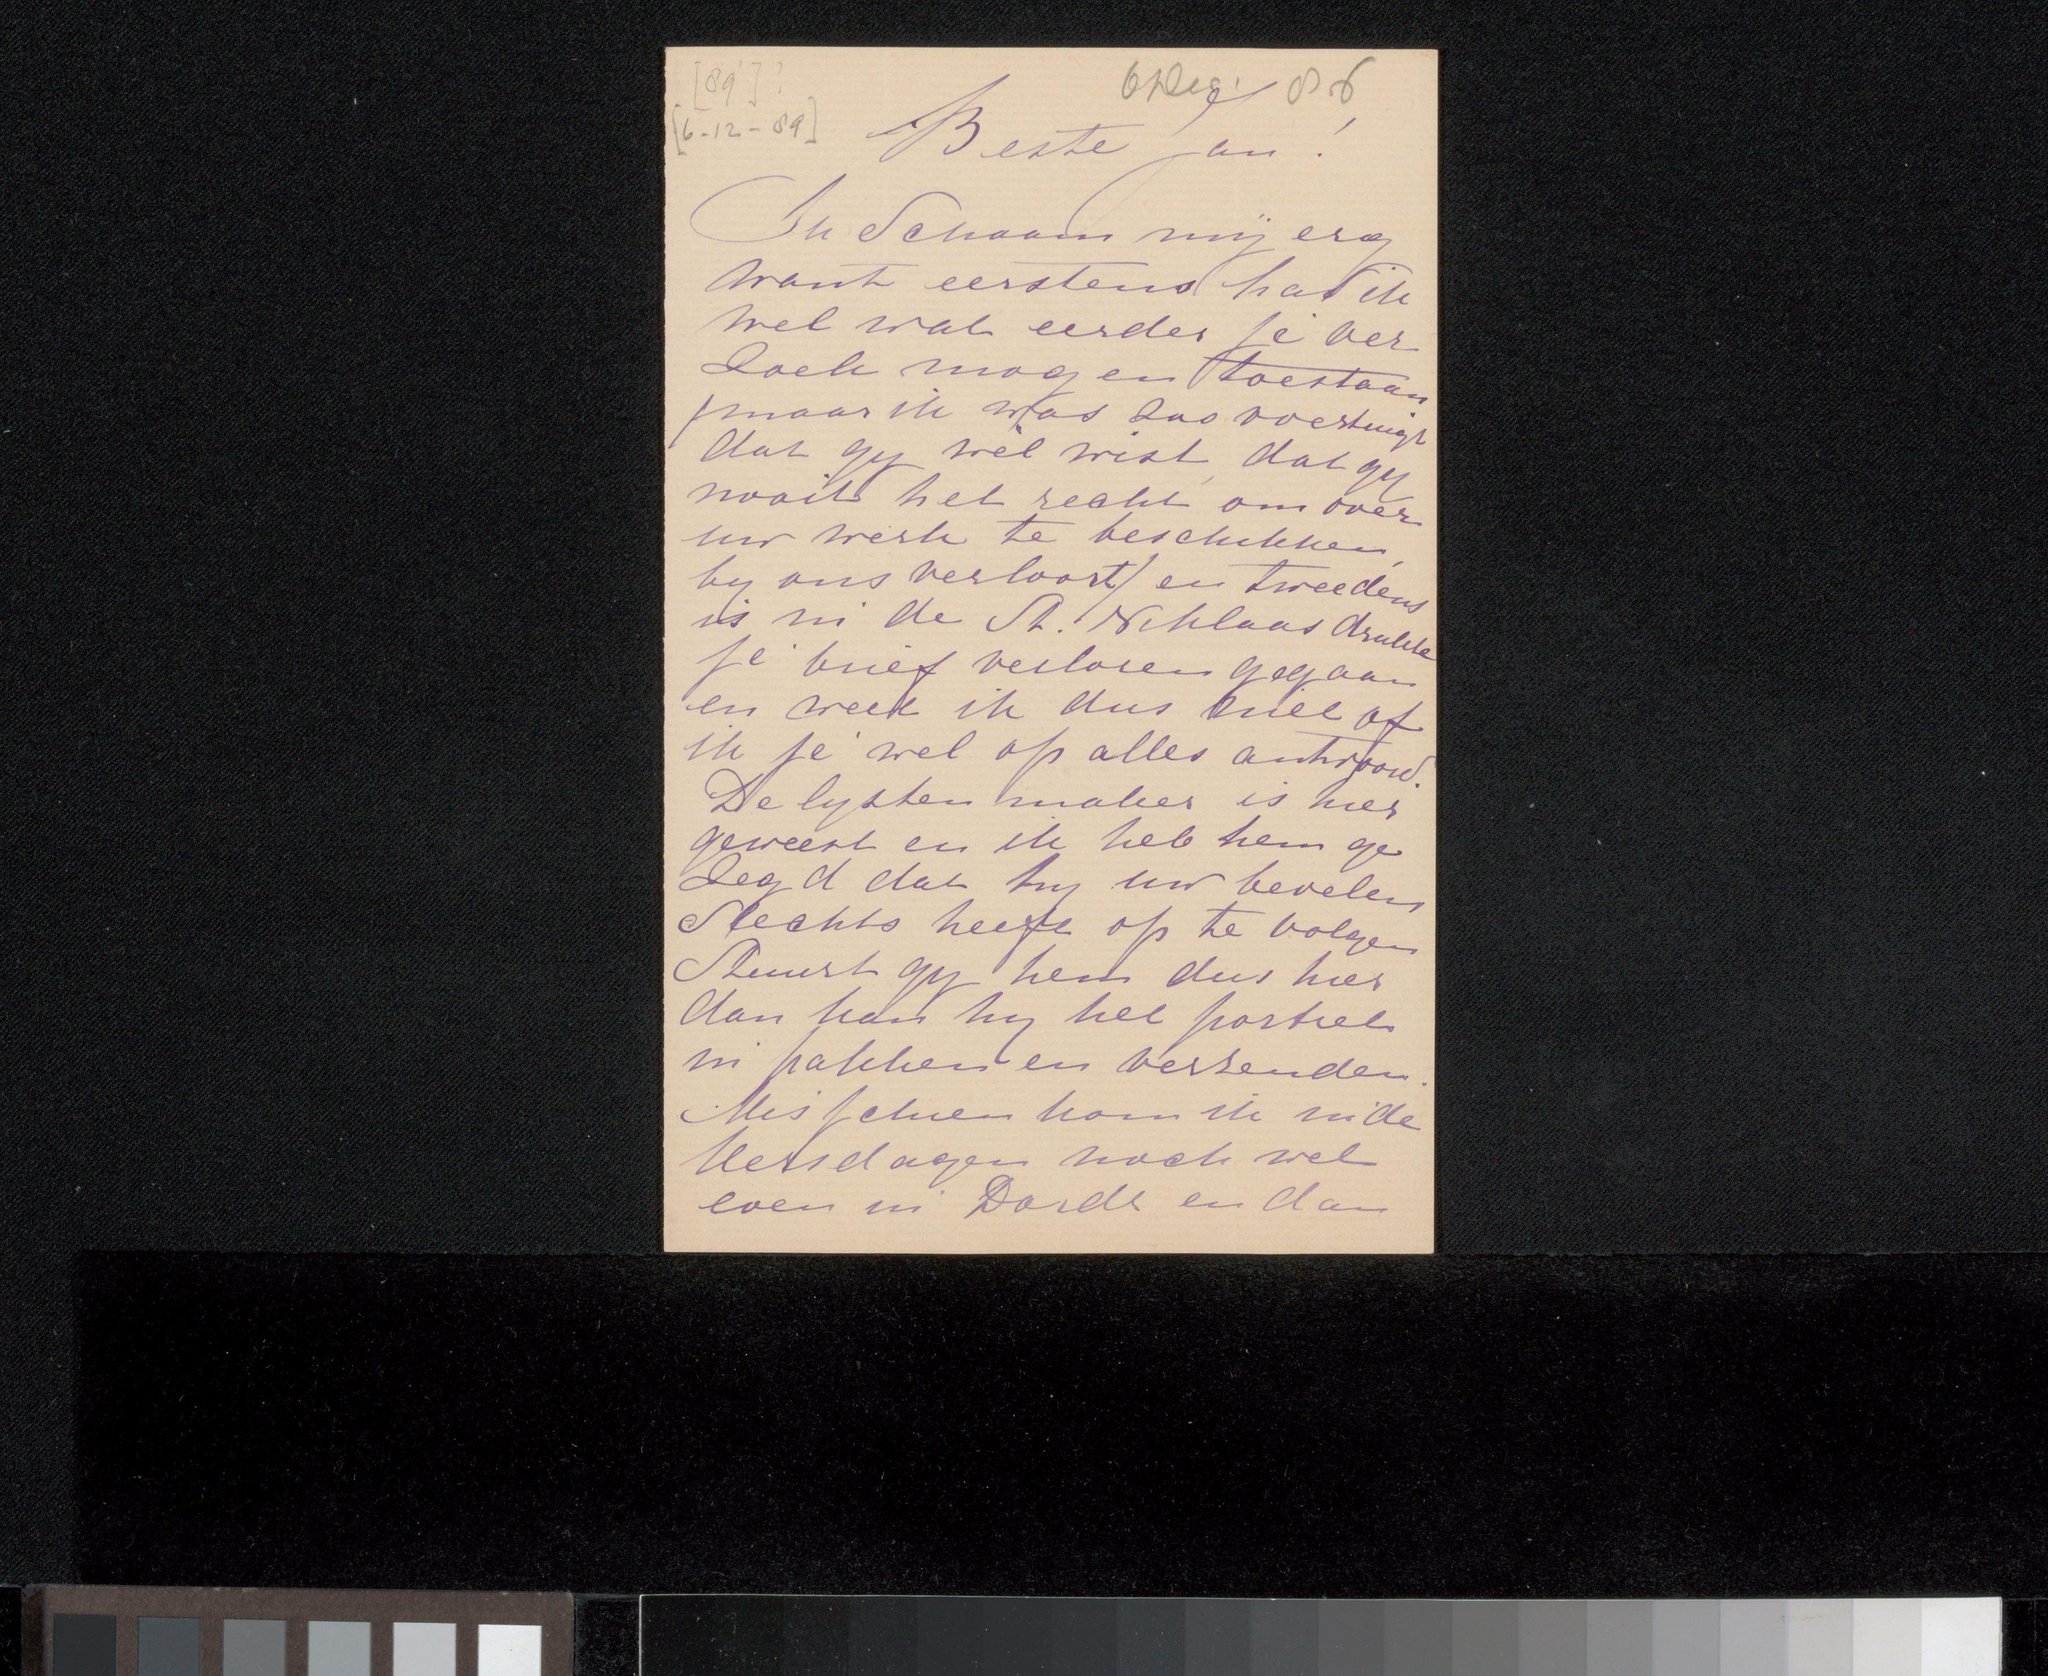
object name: letter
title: Brief aan Jan Veth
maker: jacoba cornelia jolles-singels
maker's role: schrijver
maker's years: 1847-1901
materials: ink, paper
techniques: pen, writing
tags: painter, draughtsman, designer, jan veth, historical persons (portraits and scenes from the life), dordrecht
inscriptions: collector's mark: ‘RPK’